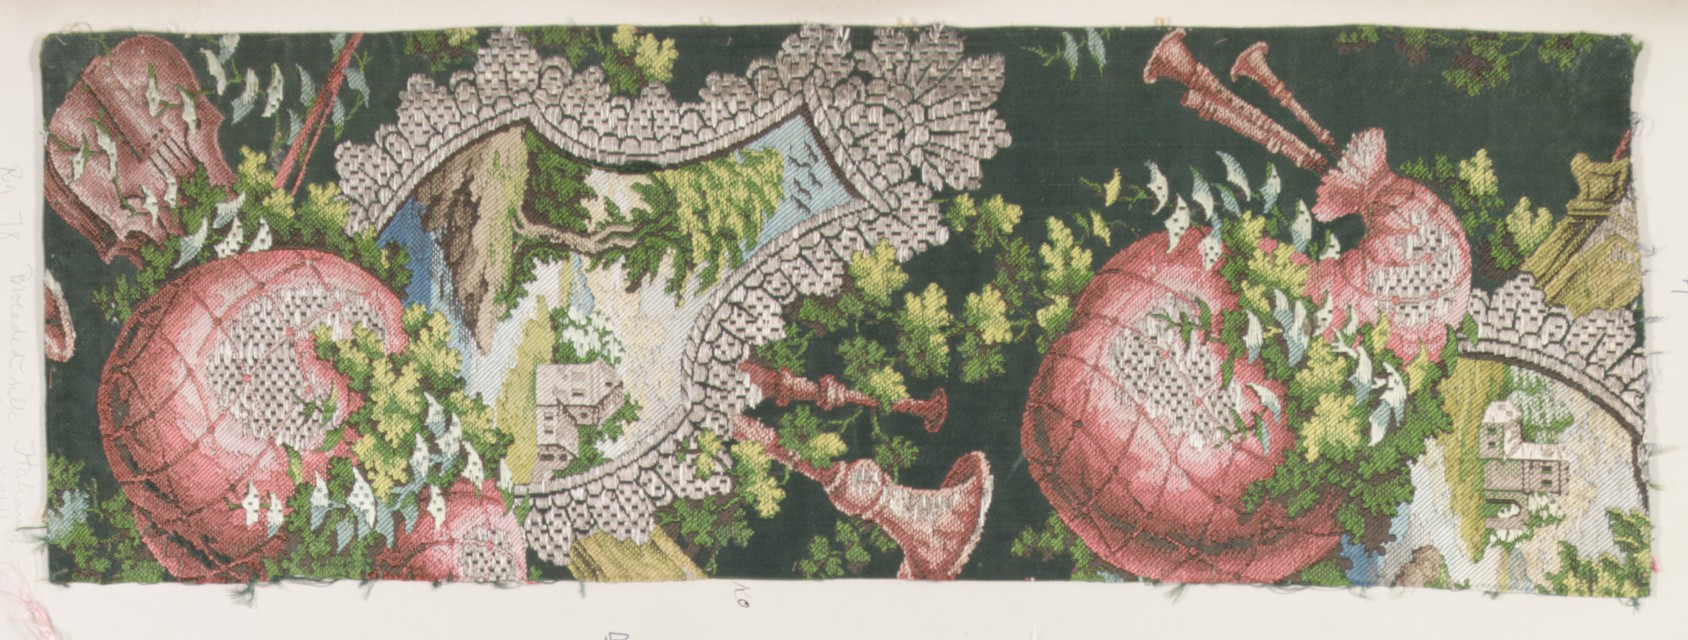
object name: fragment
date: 1730-1740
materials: metal thread, silk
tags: landscapes,leaves